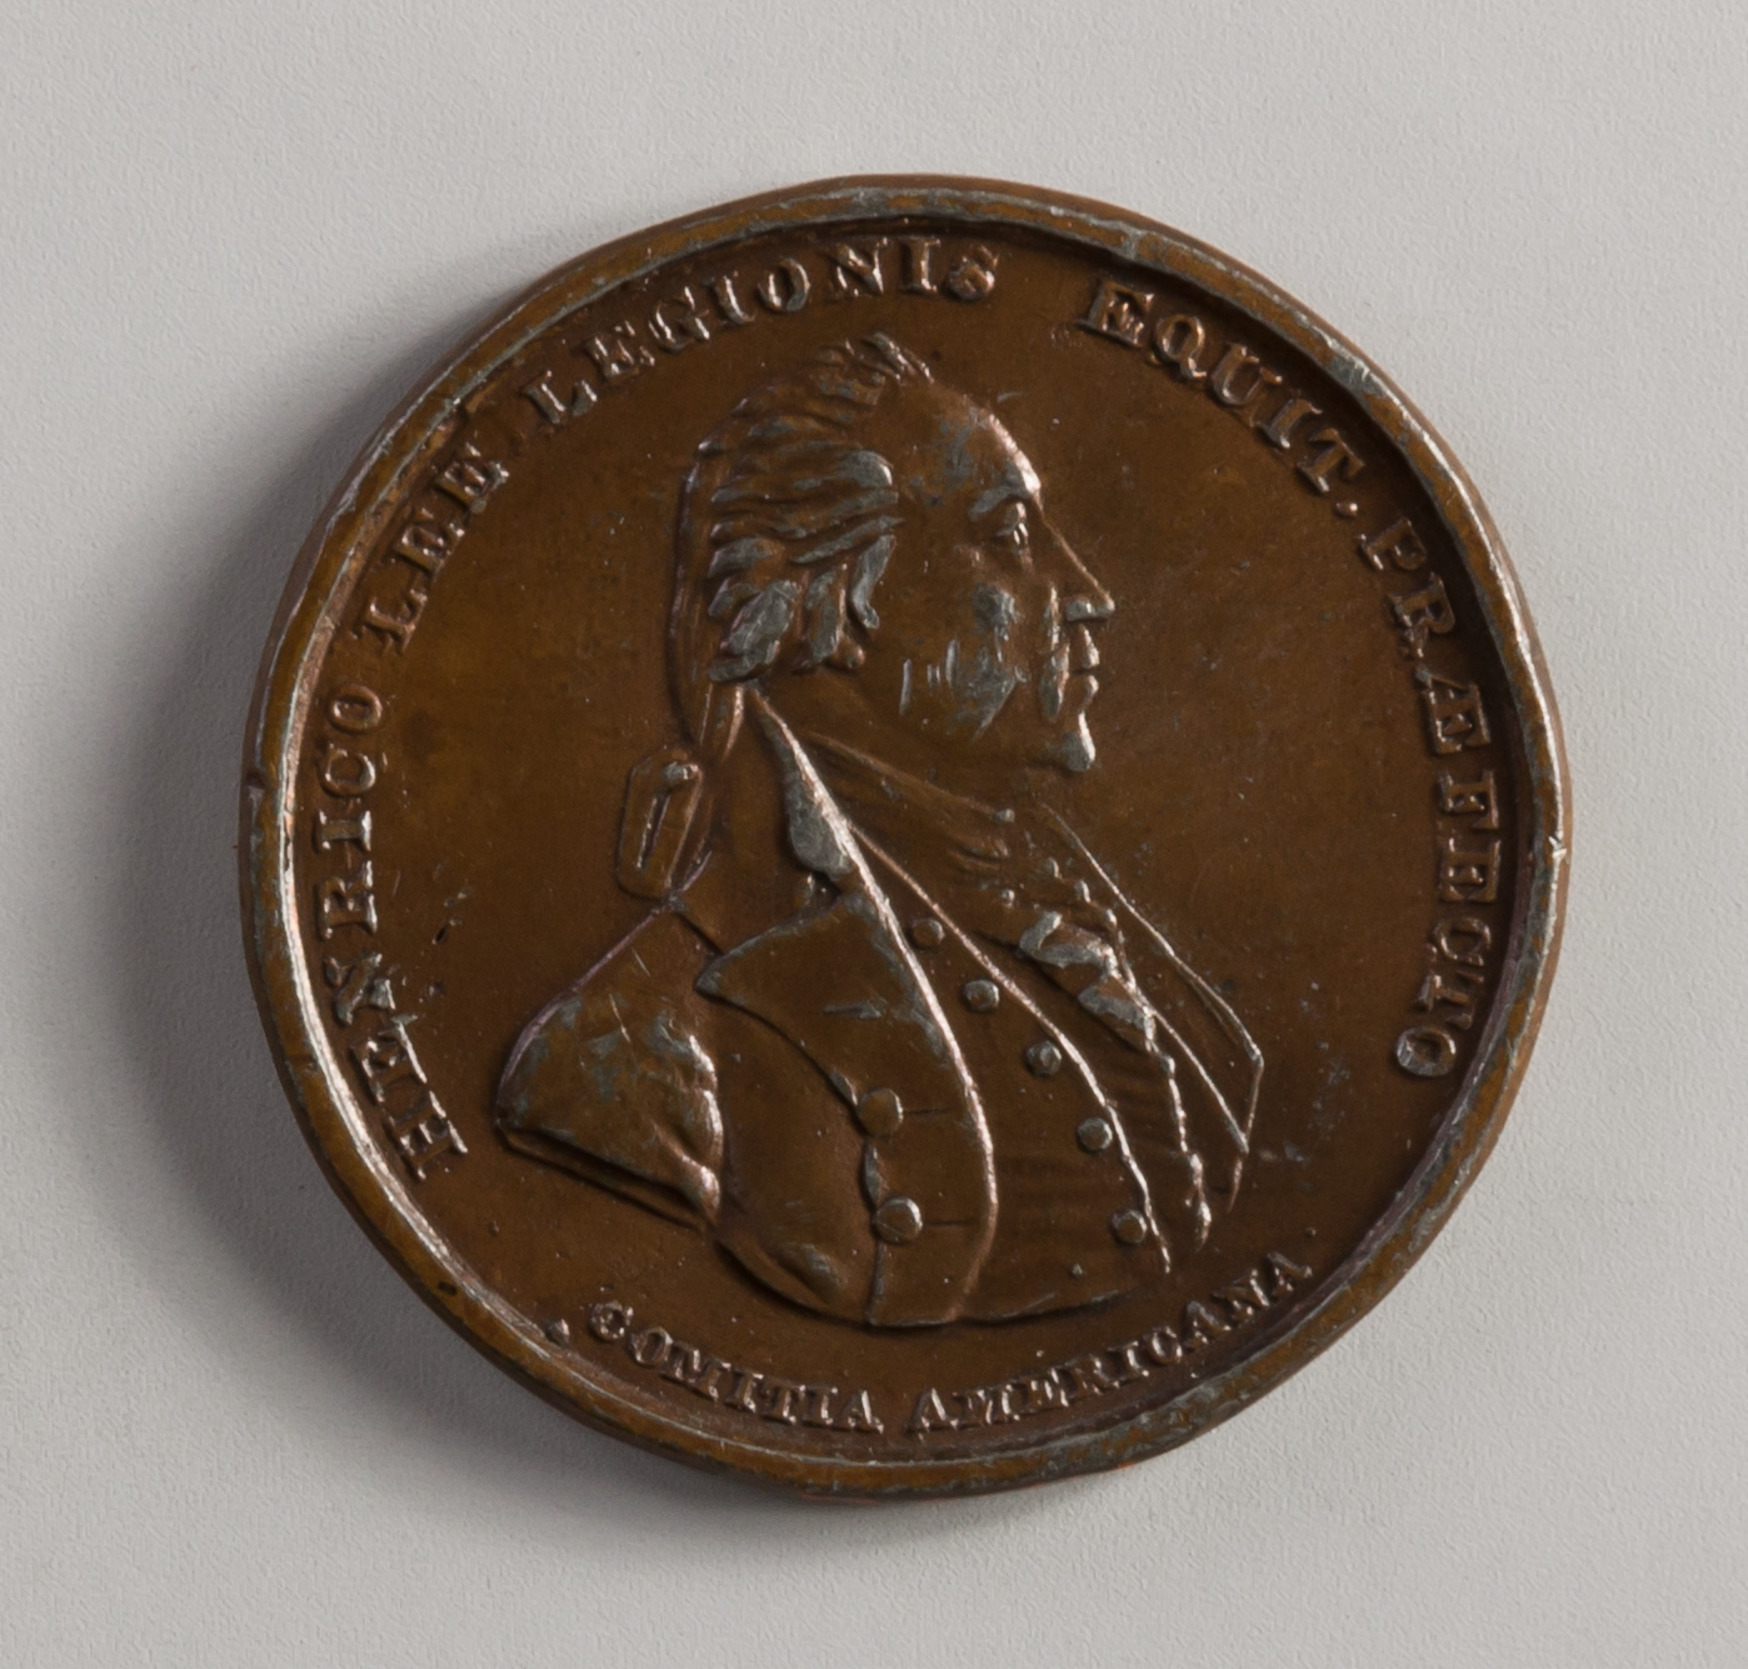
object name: medal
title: Medal of Henry Lee's Capture of the British at Paulus Hook, 1779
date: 1779-1800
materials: lead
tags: men,profiles